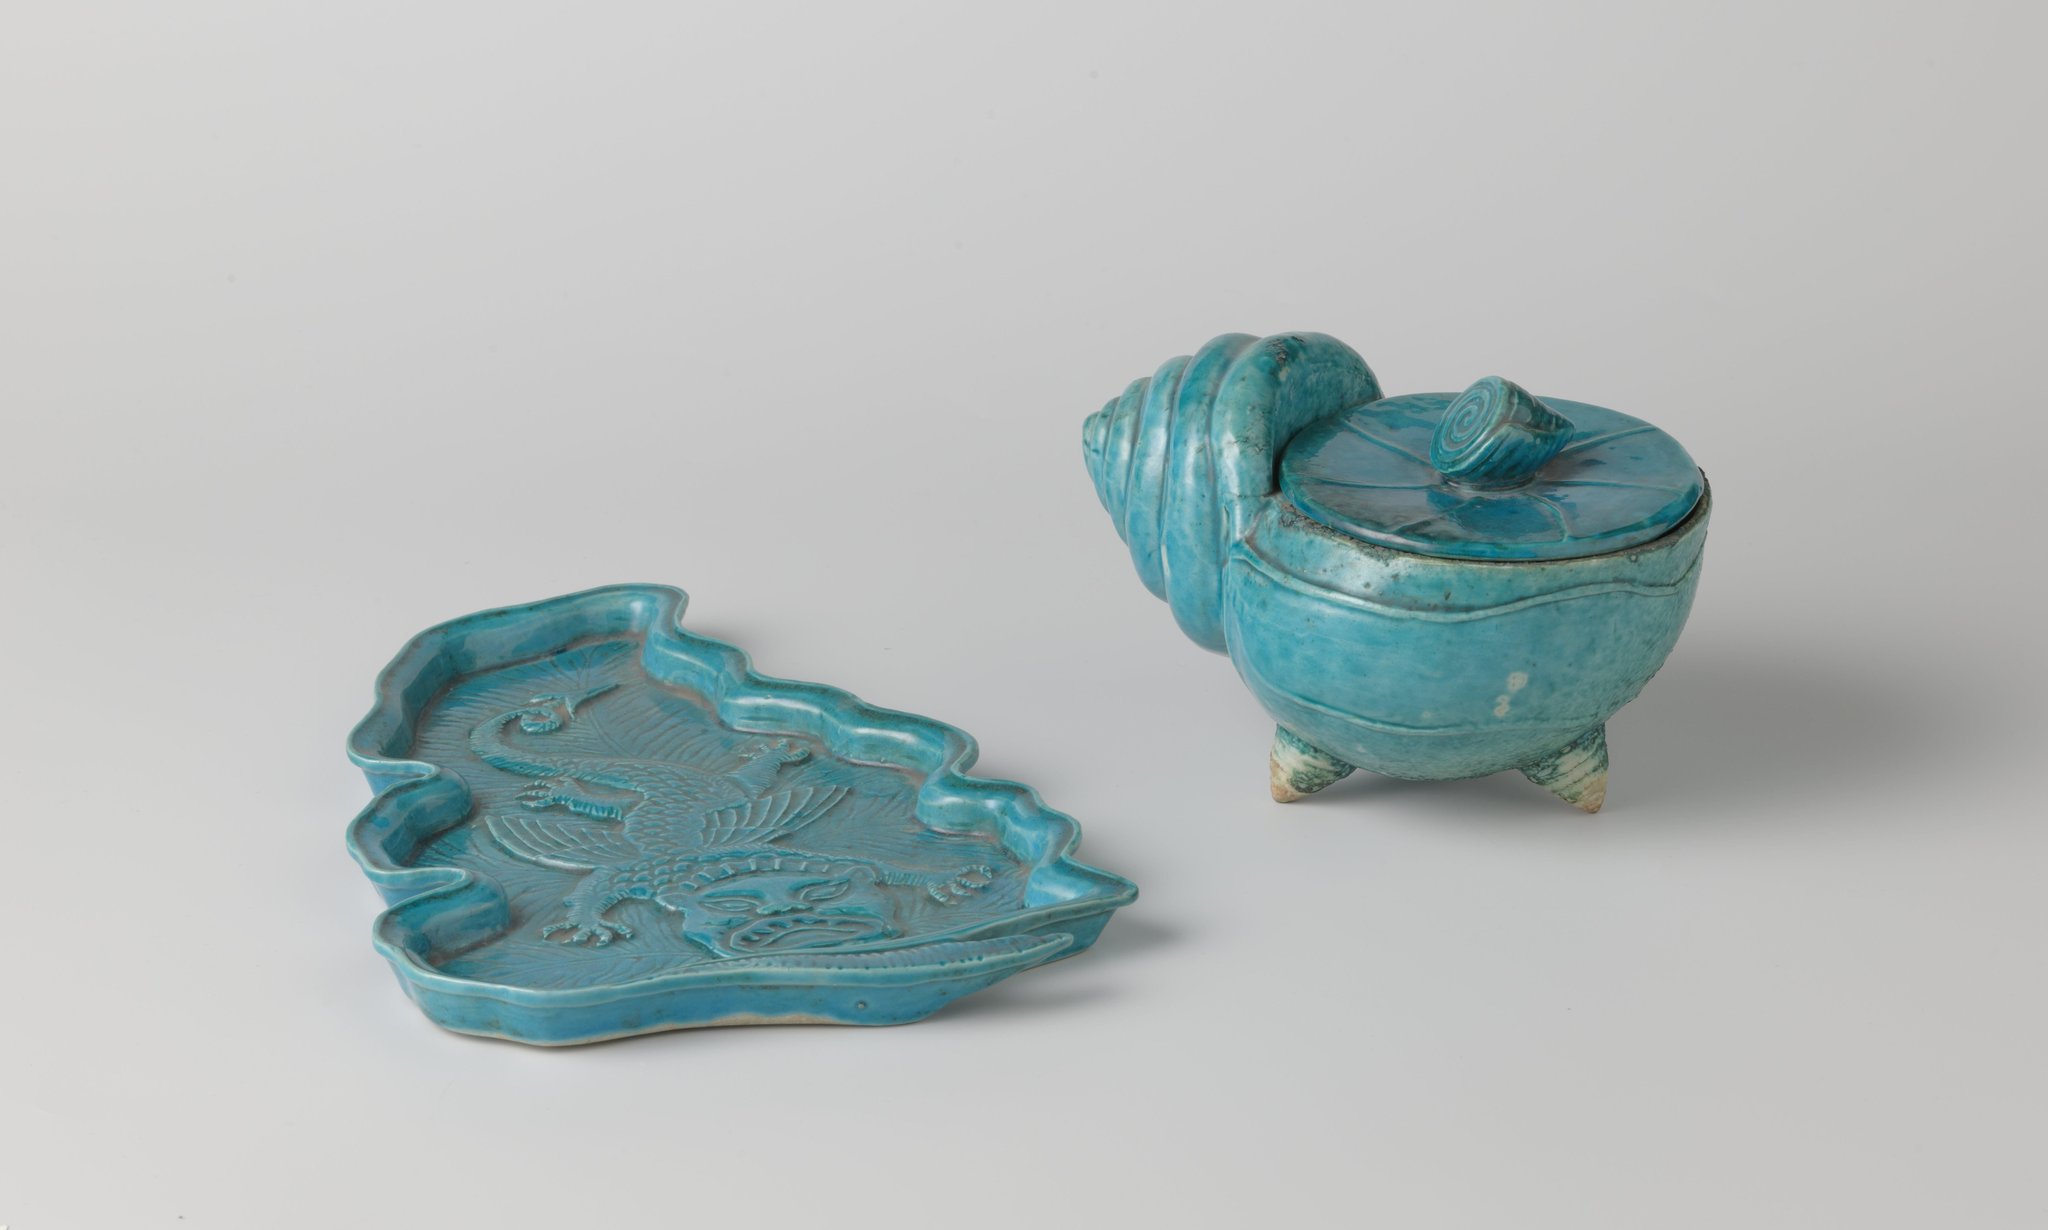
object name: slag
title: Scallop-shaped covered bowl with a leaf-shaped stand with dragon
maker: Anonymous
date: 1775-1799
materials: glaze, porcelain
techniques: firing, forming, vitrification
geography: china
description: AK-NM-6432 Kom met deksel en (niet bijpassende) onderschotel • Gekleurd – monochroom porselein • Onderdeel van Royers porseleincollectie Omdat er wordt getwijfeld of de vaasjes AK-NM-7370 en 6371 wel 18de-eeuws zijn en tot Royers verzameling hebben behoord, is deze schelp eigenlijk het enige monochrome stuk porselein dat we – zonder tegenbericht – beschouwen als onderdeel van Royers collecties. Zoals ook bij de gecraqueleerde kleine vazen het geval was, zijn vergelijkbare schelpen bekend met uitvoerige Franse vergulde monturen uit het midden van de 18de eeuw [Lunsingh Scheurleer 1980, afb. 283 (Walters Gallery), Krahl 1996, vol. II, nr. 263 (Rothschild collectie)]. Zoals bekend waren monochromen geliefd in Frankrijk, en niet in Nederland. De Franse smaak voor porselein nam aan het eind van de 17de eeuw al een andere wending dan die in Nederland. Het ging in Frankrijk in het algemeen om kleinere aantallen stukken – vaak gemonteerd – die fraai combineerden met andere kostbaarheden in een collectie. Porselein sloot aan op hardstenen voorwerpen. Terwijl in Nederland de volle Marot-opstellingen nog lang na-ijlden, bestond in Frankrijk vaak al een grotere aandacht en kieskeurigheid voor afzonderlijke stukken. Dit komt naar voren in de manier waarop porselein in veilingcatalogi van vooraanstaande collecties beschreven wordt [Castelluccio 2013]. In de catalogus van de veiling van de collectie Randon de Boisset uit 1777 staat bijvoorbeeld: ‘par le ton doux & distingué de sa couleur… elle donne une variété brillant, étant artisement distribuée dans un cabinet.’ [Castelluccio 2013, p. 156 en cat. Randon de Bossiet 1777 (Lugtnr. 2652) vol. II, p. 74]. De voorliefde voor bleu céleste, de term die voor deze kleur blauw [maar ook voor het lichtere turkoois?] komt ook tot uitdrukking in de Sèvres schelpen, met precies deze vorm en een iets lichter maar toch zeer overeenkomstig glazuur. Deze Franse stukken kunnen gedateerd worden tussen 1763 en 1768 [Jarry 1981, pl. 125]. Voor de onderschotel heb ik geen vergelijkbare exemplaren in andere collecties kunnen vinden. De gedachtegang ‘dit is zo lelijk, dus het moet wel 19de-eeuws zijn’ is aanlokkelijk, maar de vreemde monsters zijn ook te vinden op een dekselpot met dit glazuur, voorzien van een Frans montuur uit het midden van de 18de eeuw [Jarry 1981, pl. 230]. Deze Franse manier van verzamelen was slechts van geringe betekenis voor de porseleinappreciatie in Nederland. Maar het lijkt me sterk dat het geheel onbekend was. Een zeer belangrijke porseleincollectie uit deze tijd, die van de gebroeders Bisschop (geveild 1771) lijkt deels gemodelleerd naar Frans voorbeeld. Natuurlijk keek men naar Franrijk, het internationale ijkpunt van de goede smaak! Ik ga er daarom vanuit dat ook Royer op de hoogte was van deze Franse smaak voor Chinees (en Japans) porselein en dat dat een stimulans kan zijn geweest deze schelp aan zijn collectie toe te voegen. Bronnen: Daniel François Lunsingh Scheurleer, Chinesisches und japanisches Porzellan in europäischen Fassungen, Braunschweig, 1980. Madeleine Jarry, Chinoiseries: le rayonnement du goût chinois sur les arts décoratifs des XVIIe et XVIIIe siècles, Fribourg, 1981. Regina Krahl, The Anthony de Rothschild collection of Chinese ceramics, Londen, 1996. Stephane Castelluccio, Collecting Chinese and Japanese porcelain in pre-revolutionary Paris, Los Angeles, 2013.